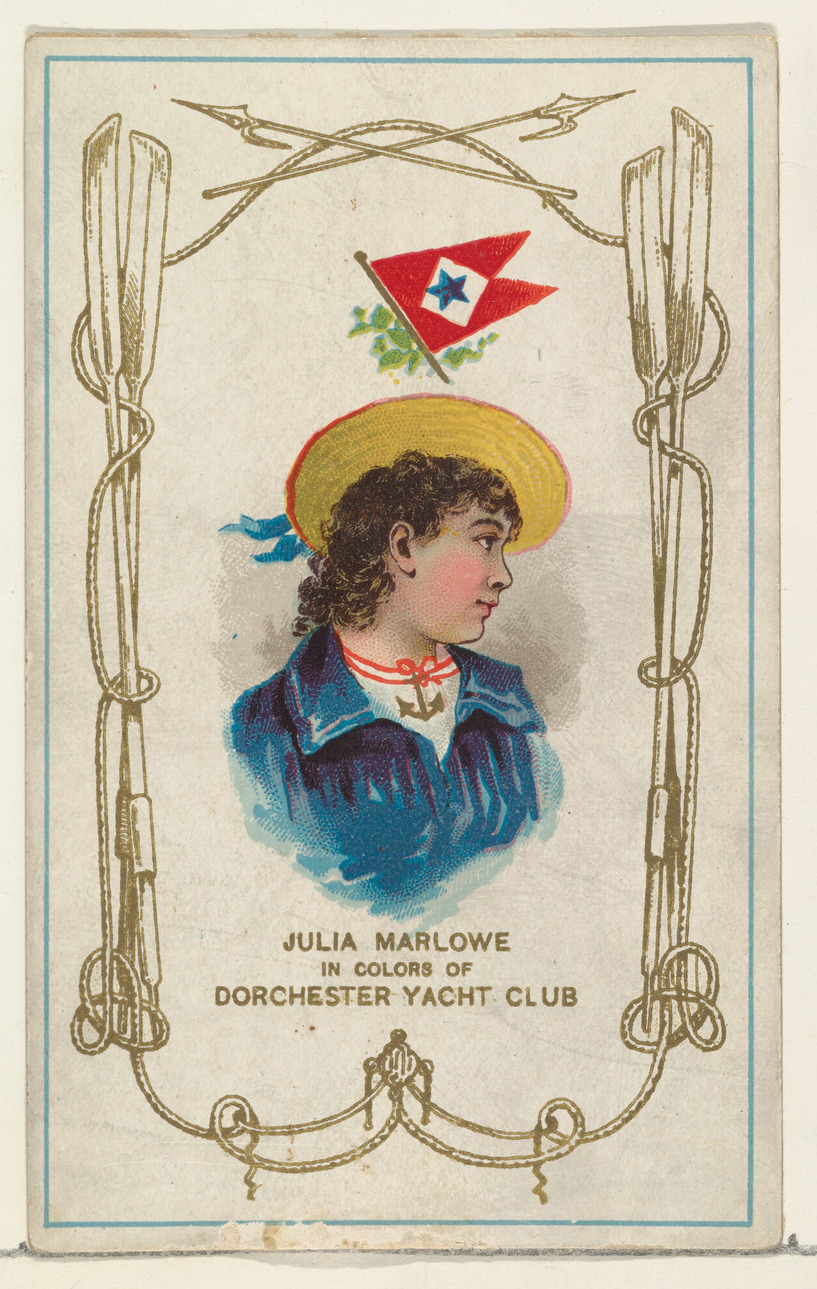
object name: print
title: Julia Marlowe in Colors of Dorchester Yacht Club, from the Yacht Colors of the World series (N140) issued by Duke Sons & Co. to promote Honest Long Cut Tobacco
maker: w. duke, sons & co.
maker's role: publisher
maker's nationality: american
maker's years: 1870-1920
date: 1890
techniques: color lithograph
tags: profiles,women,flags